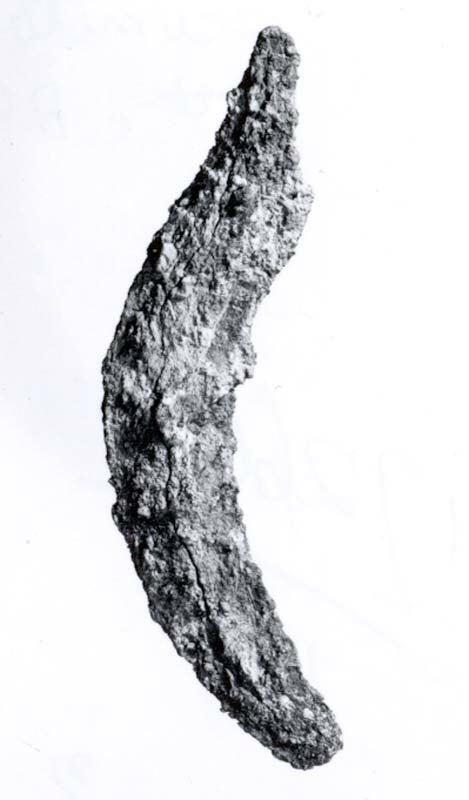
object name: sickle or pruning tool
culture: iranian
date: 900-801 BCE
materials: iron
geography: iran